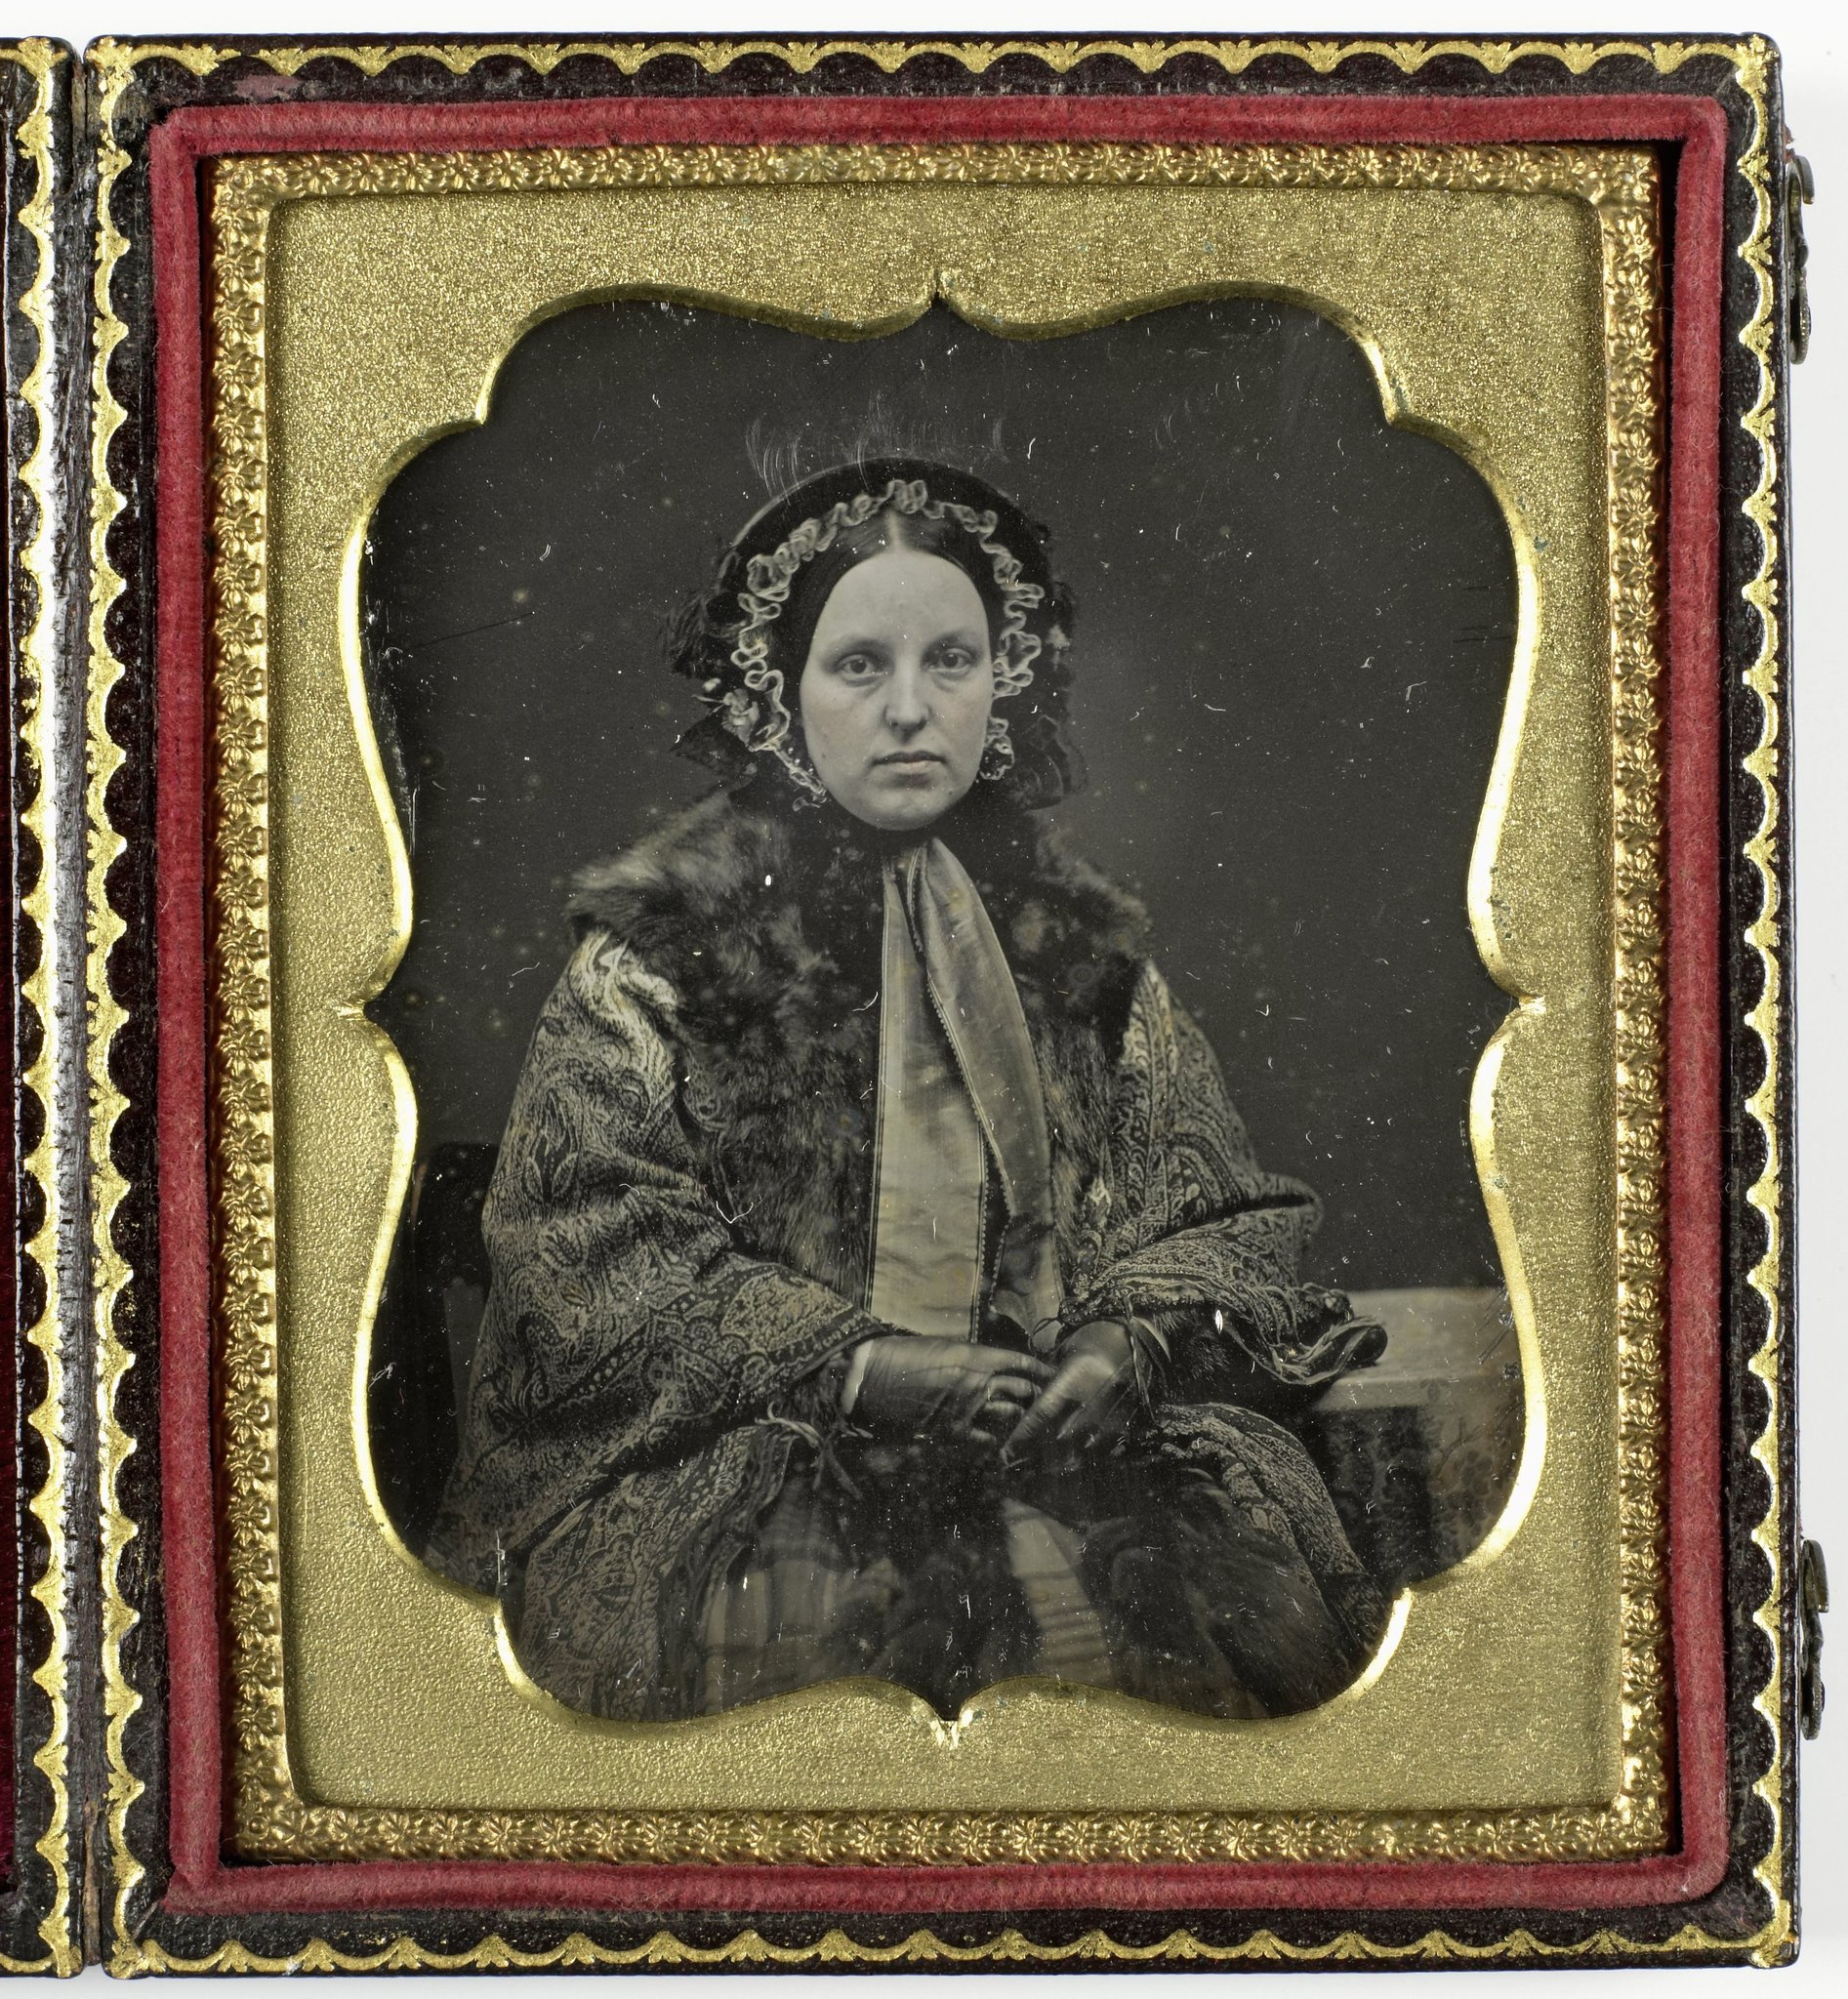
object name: photograph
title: Portret van een onbekende vrouw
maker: Anonymous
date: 1840-1860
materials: copper, glass, leather, velvet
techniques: daguerreotype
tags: adult woman, historical persons